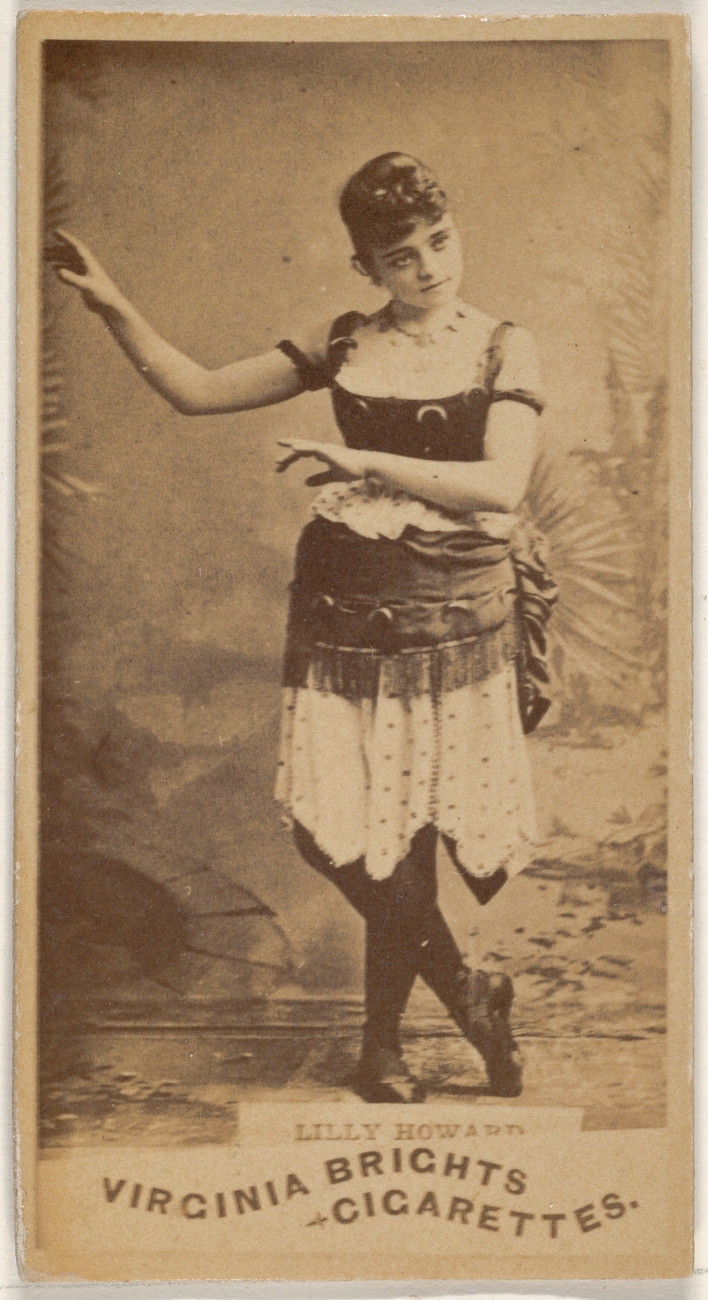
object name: photograph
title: Lilly Howard, from the Actors and Actresses series (N45, Type 1) for Virginia Brights Cigarettes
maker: allen & ginter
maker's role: publisher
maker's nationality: american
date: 1888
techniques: albumen silver print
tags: portraits,women,actresses